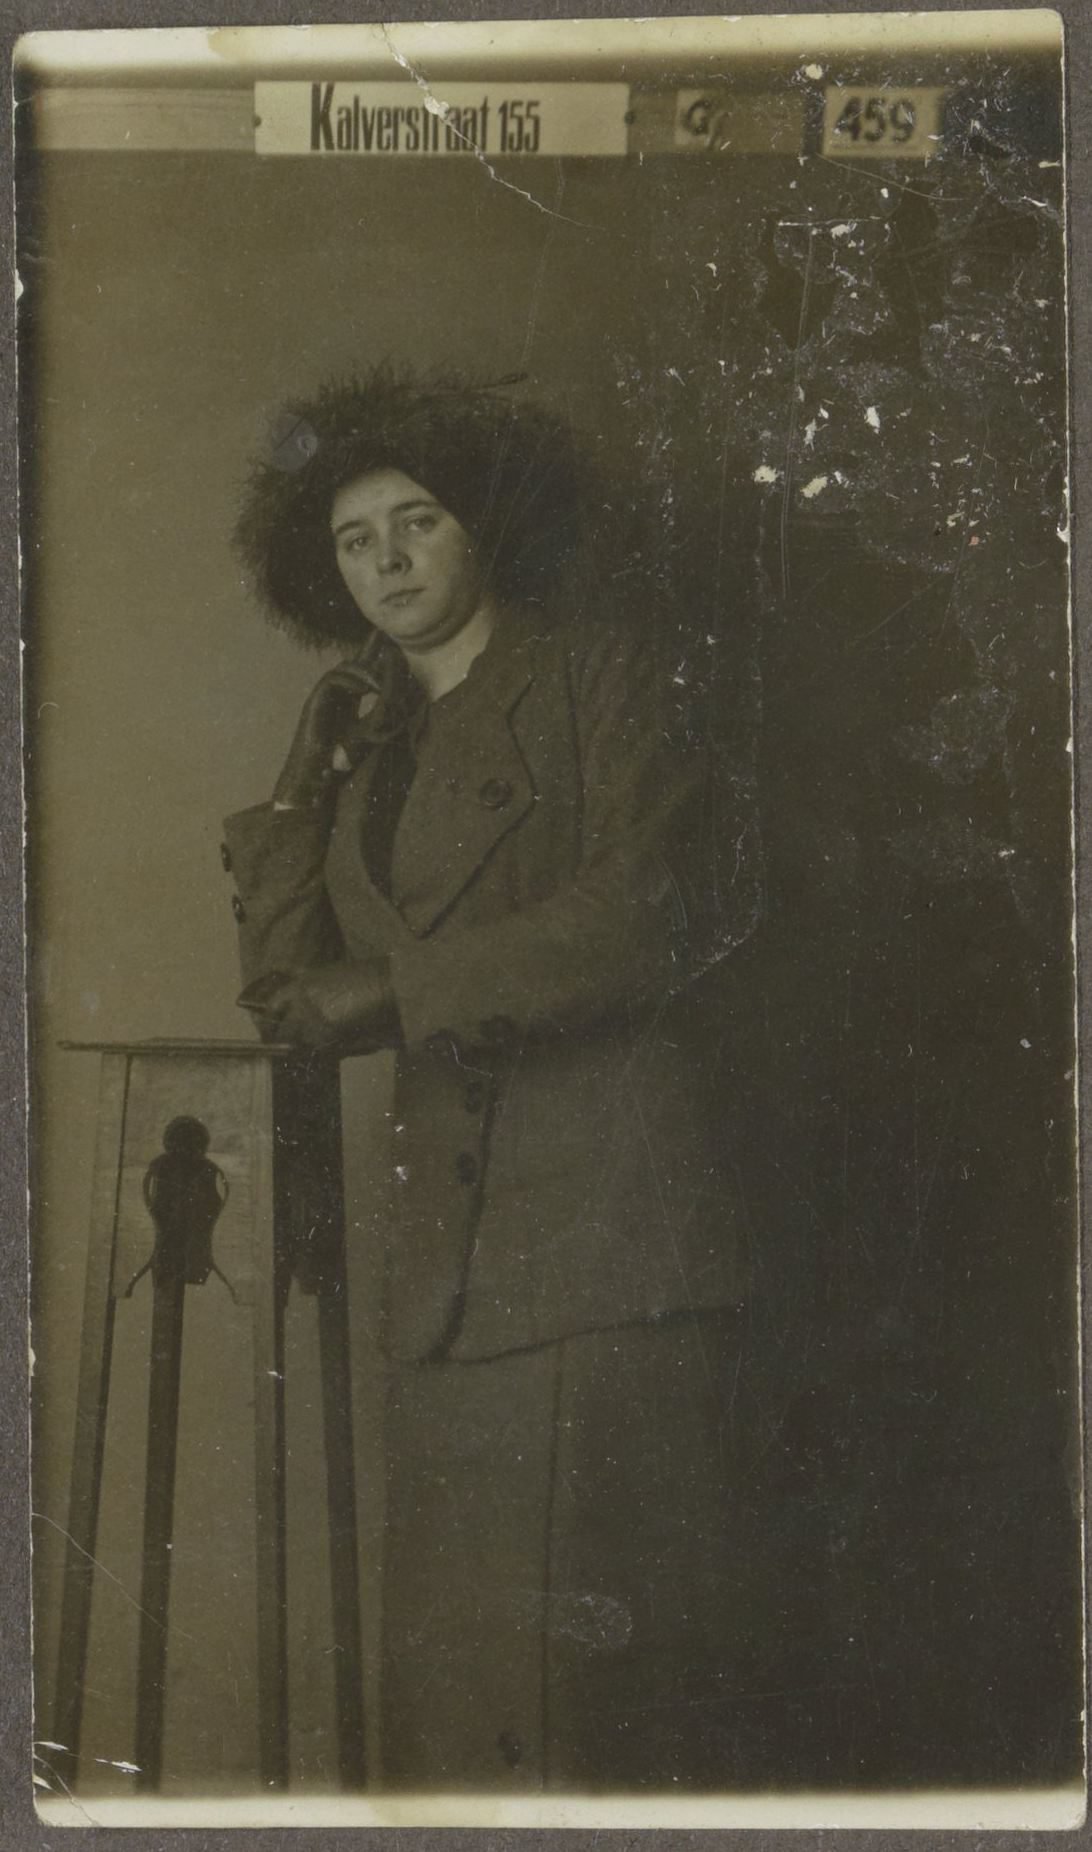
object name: album leaf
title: Portret van een vrouw met een muts, leunend op een piëdestal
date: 1913-1914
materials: paper, cardboard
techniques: gelatin silver print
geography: amsterdam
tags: adult woman, studio requisites ~ photographer, historical persons, head-gear: hat, amsterdam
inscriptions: address: ‘Kalverstraat 155’, number: ‘459’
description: Onderdeel van Fotoalbum met portretten vervaardigd door Nederlandse studio's waaronder automaatfoto's.